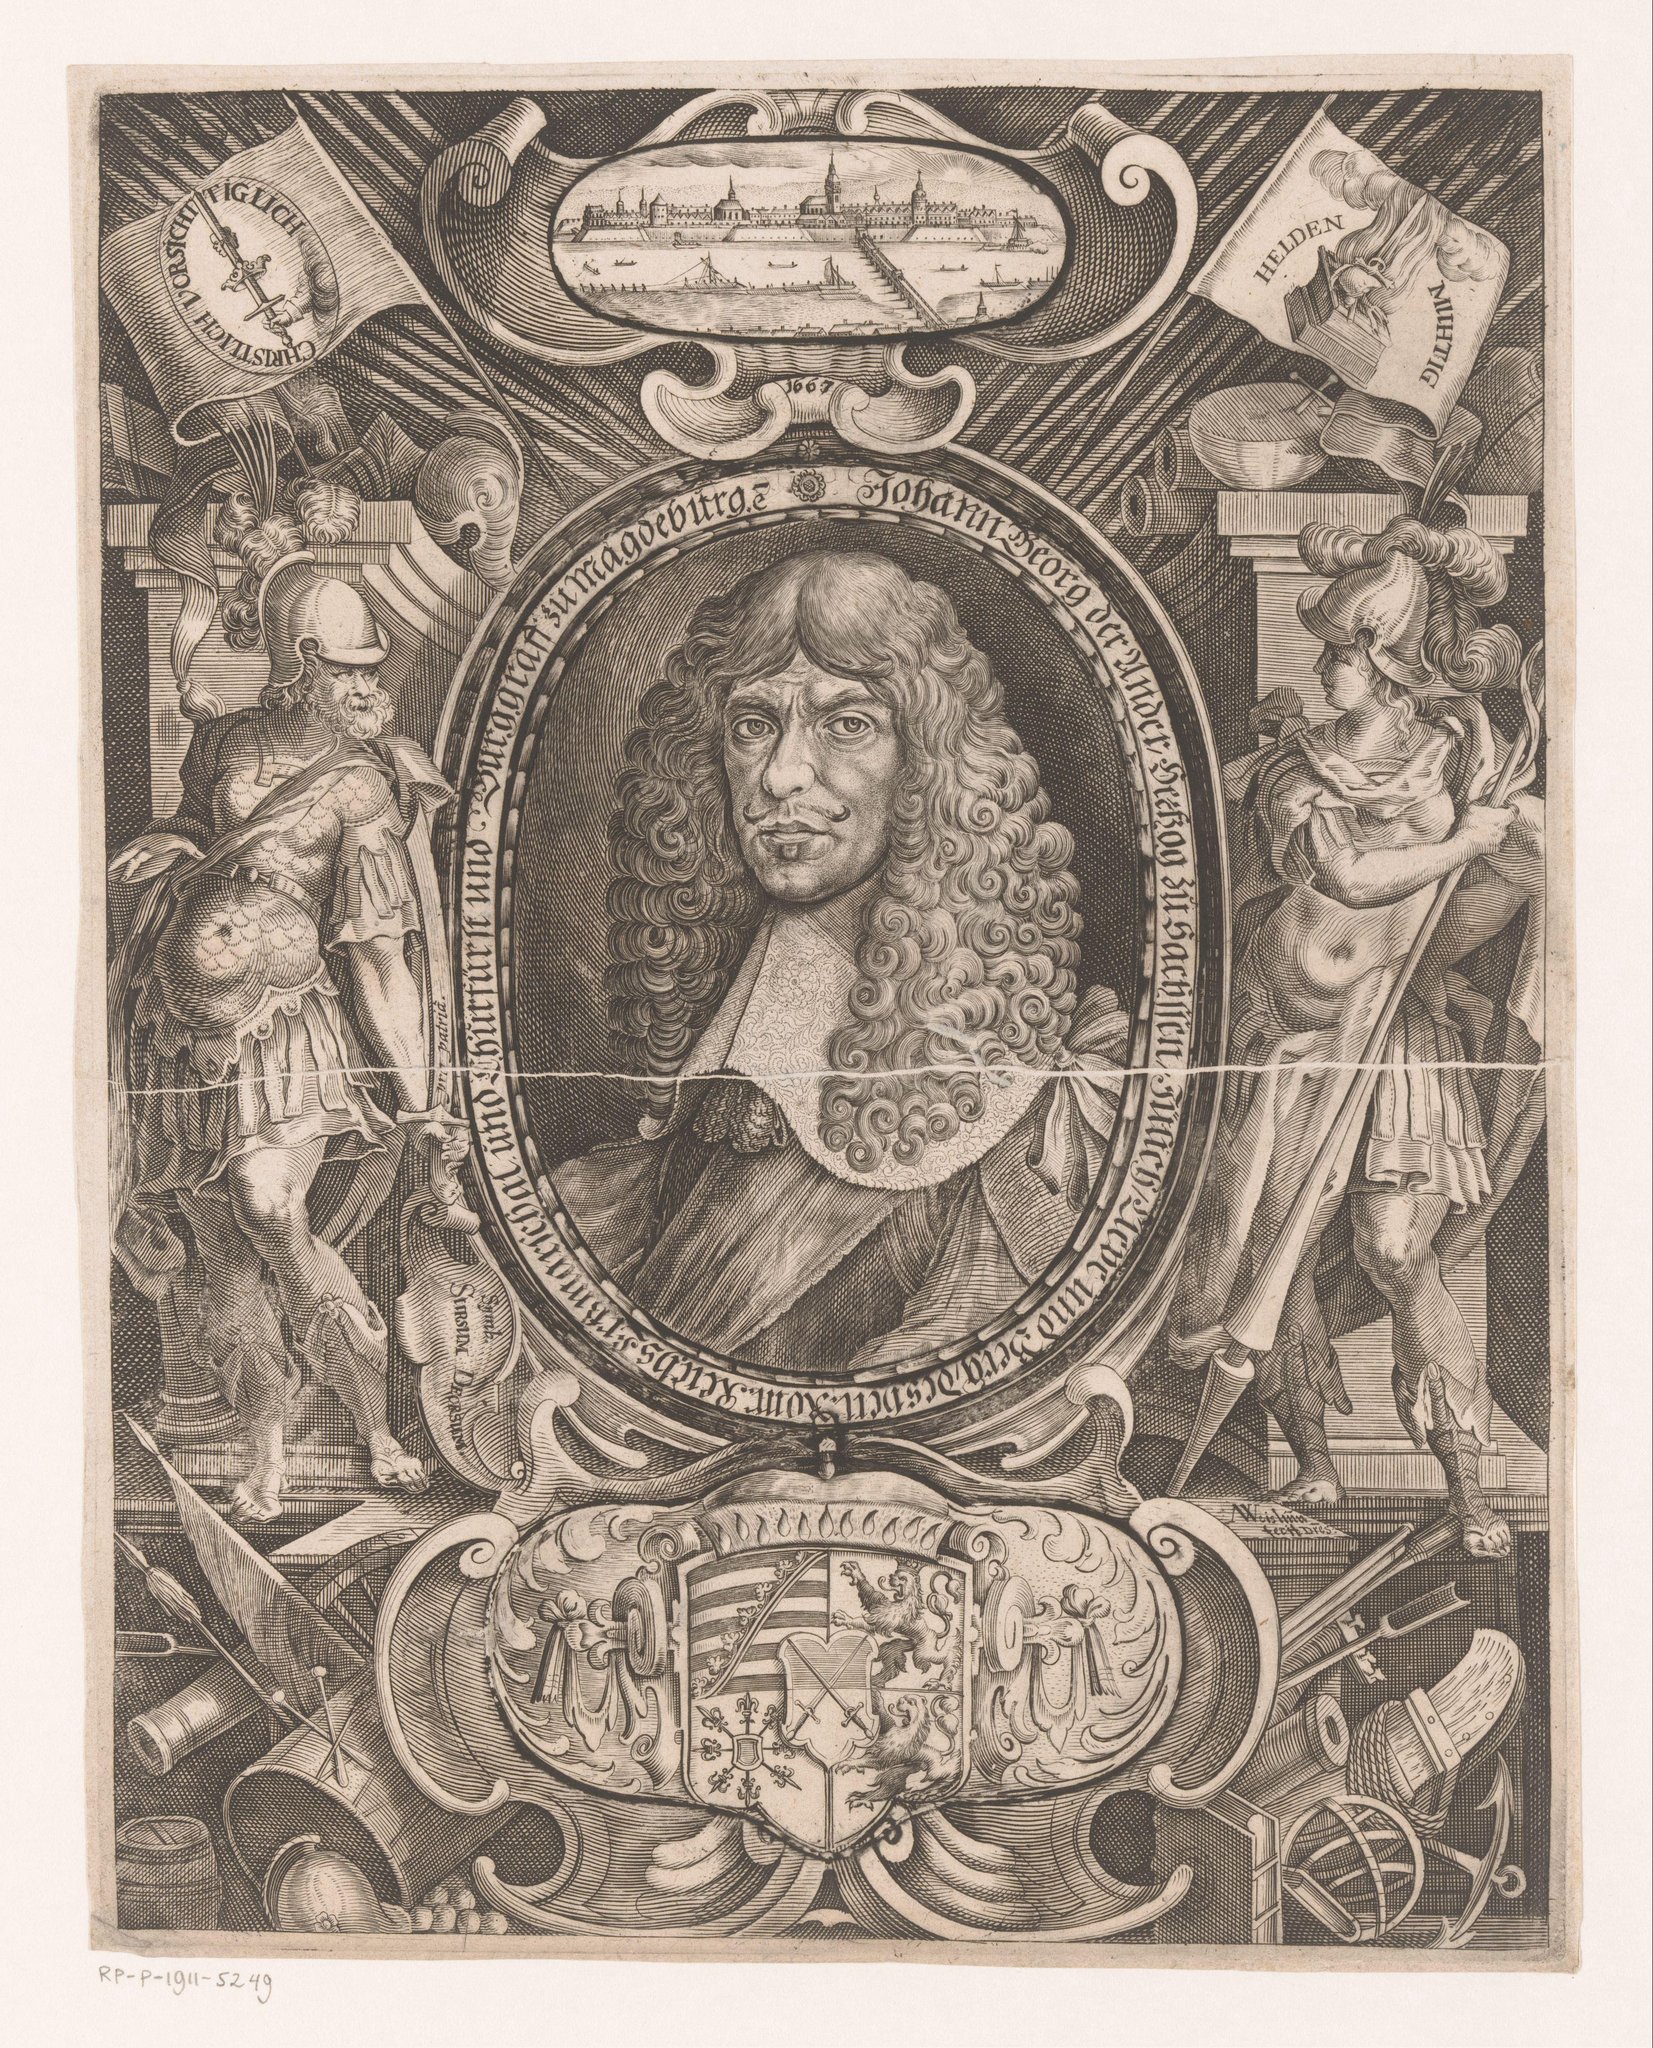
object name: print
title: Portret van Johan Georg II, keurvorst van Saksen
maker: nicolaus weishun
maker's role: print maker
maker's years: 1607-1687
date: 1667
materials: paper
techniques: engraving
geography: dresden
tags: city-view in general; 'veduta', historical persons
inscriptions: collector's mark: Lugt 2228